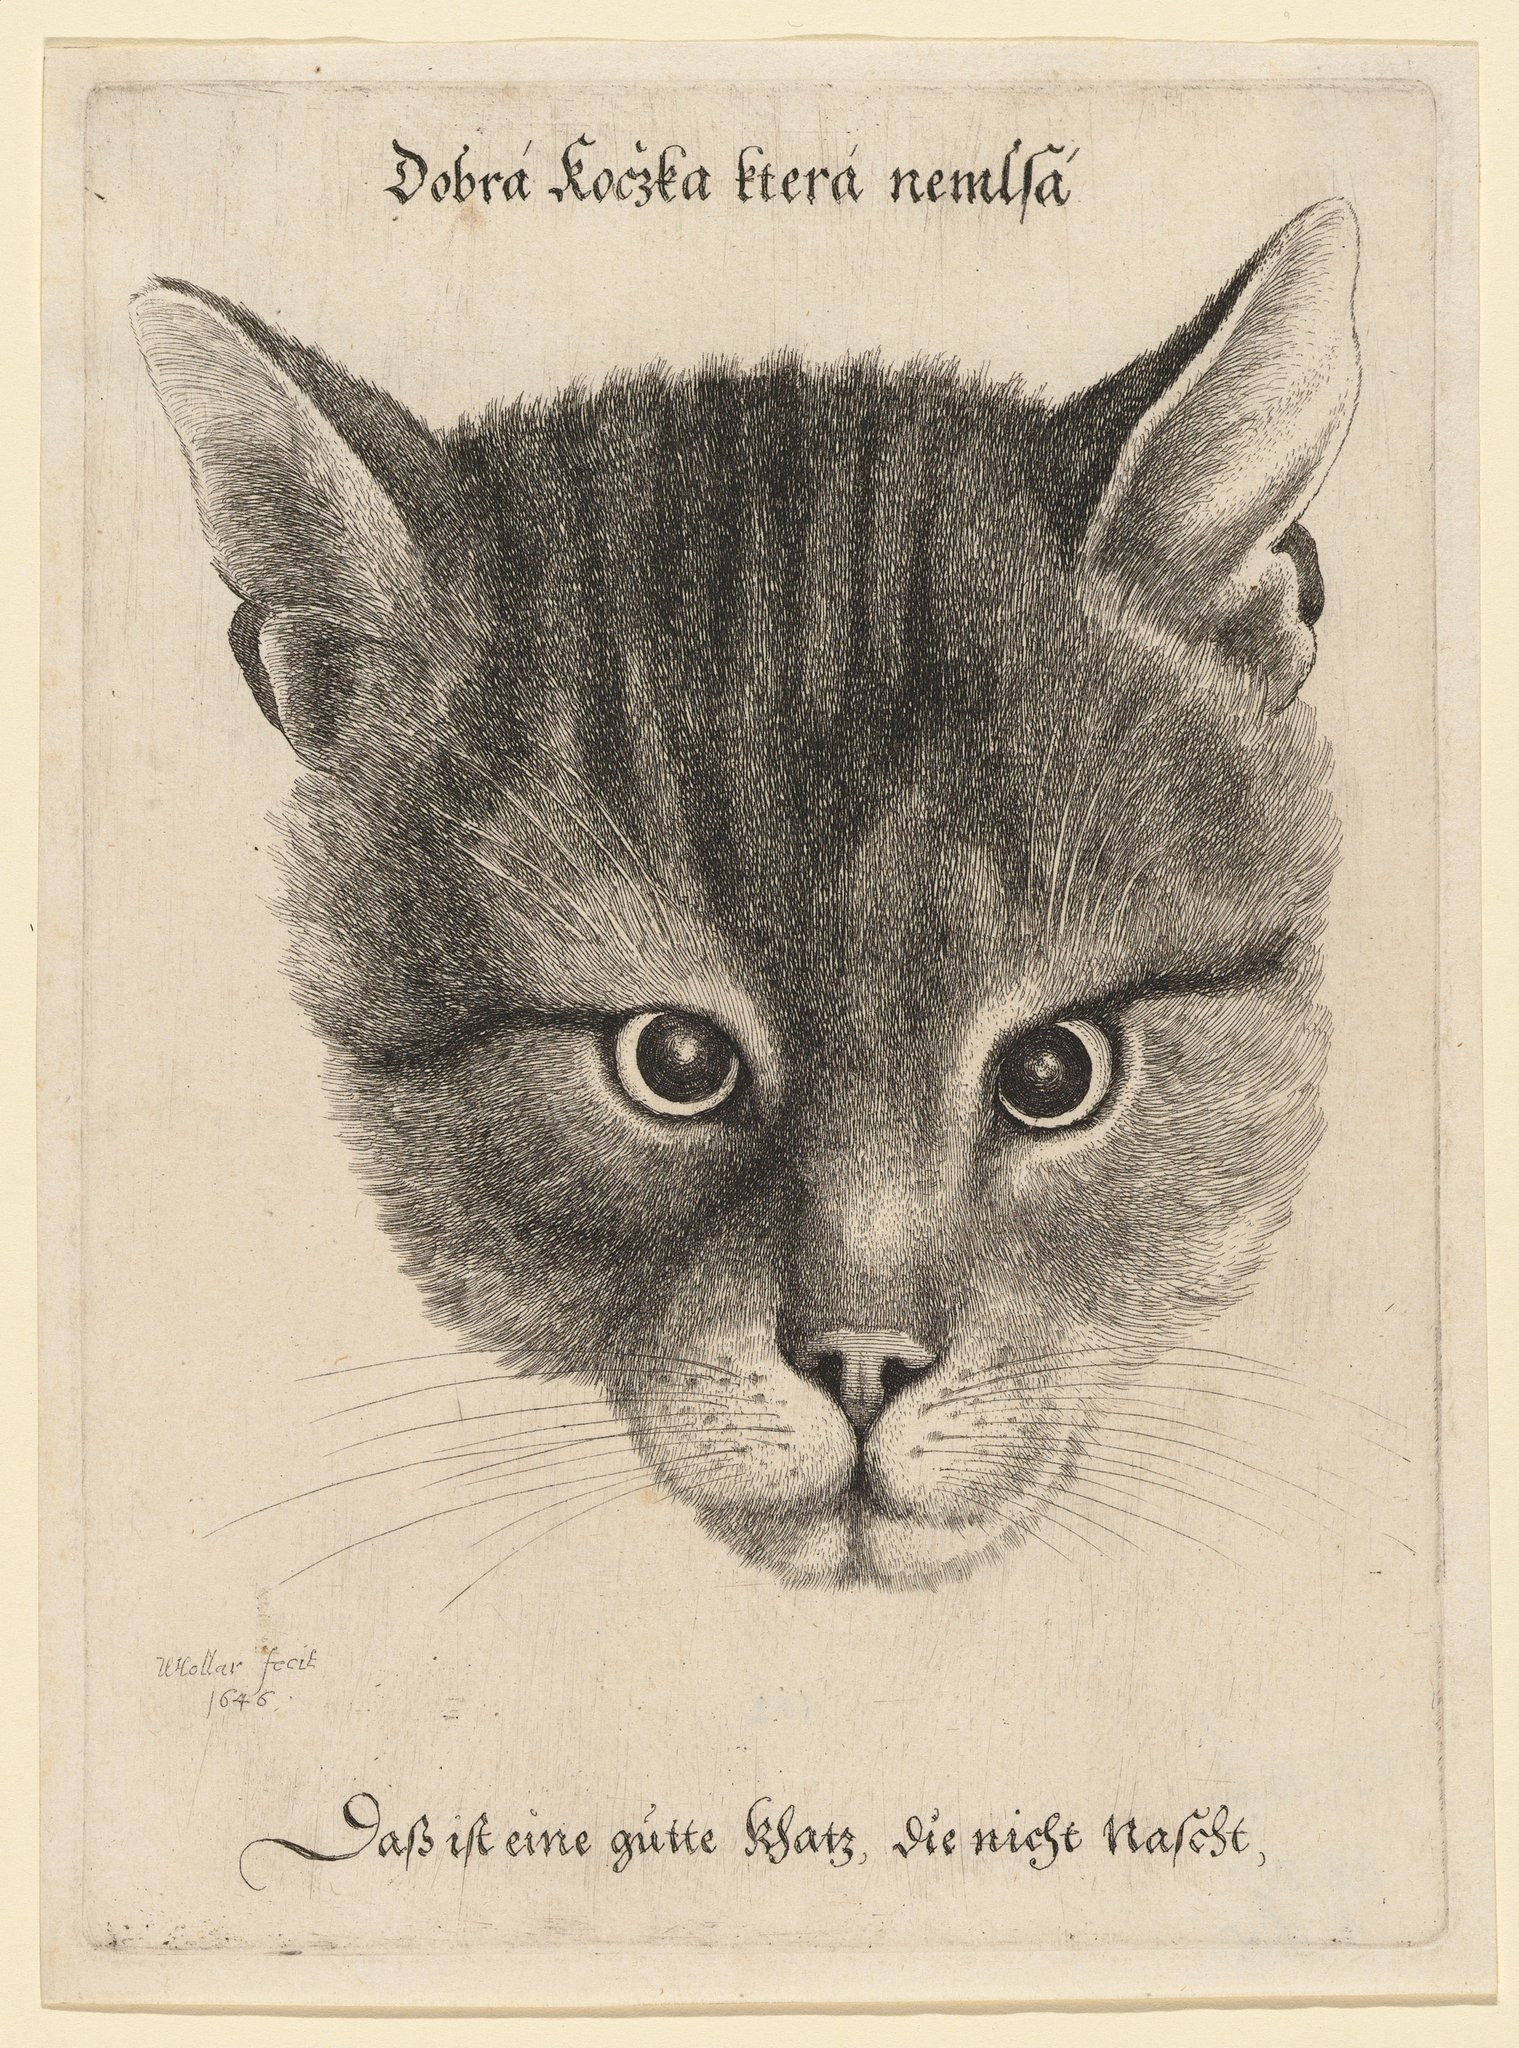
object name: print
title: Head of a Cat (Middle Size)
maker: wenceslaus hollar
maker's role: artist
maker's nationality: bohemian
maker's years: 1607-1677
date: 1646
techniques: etching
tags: cats